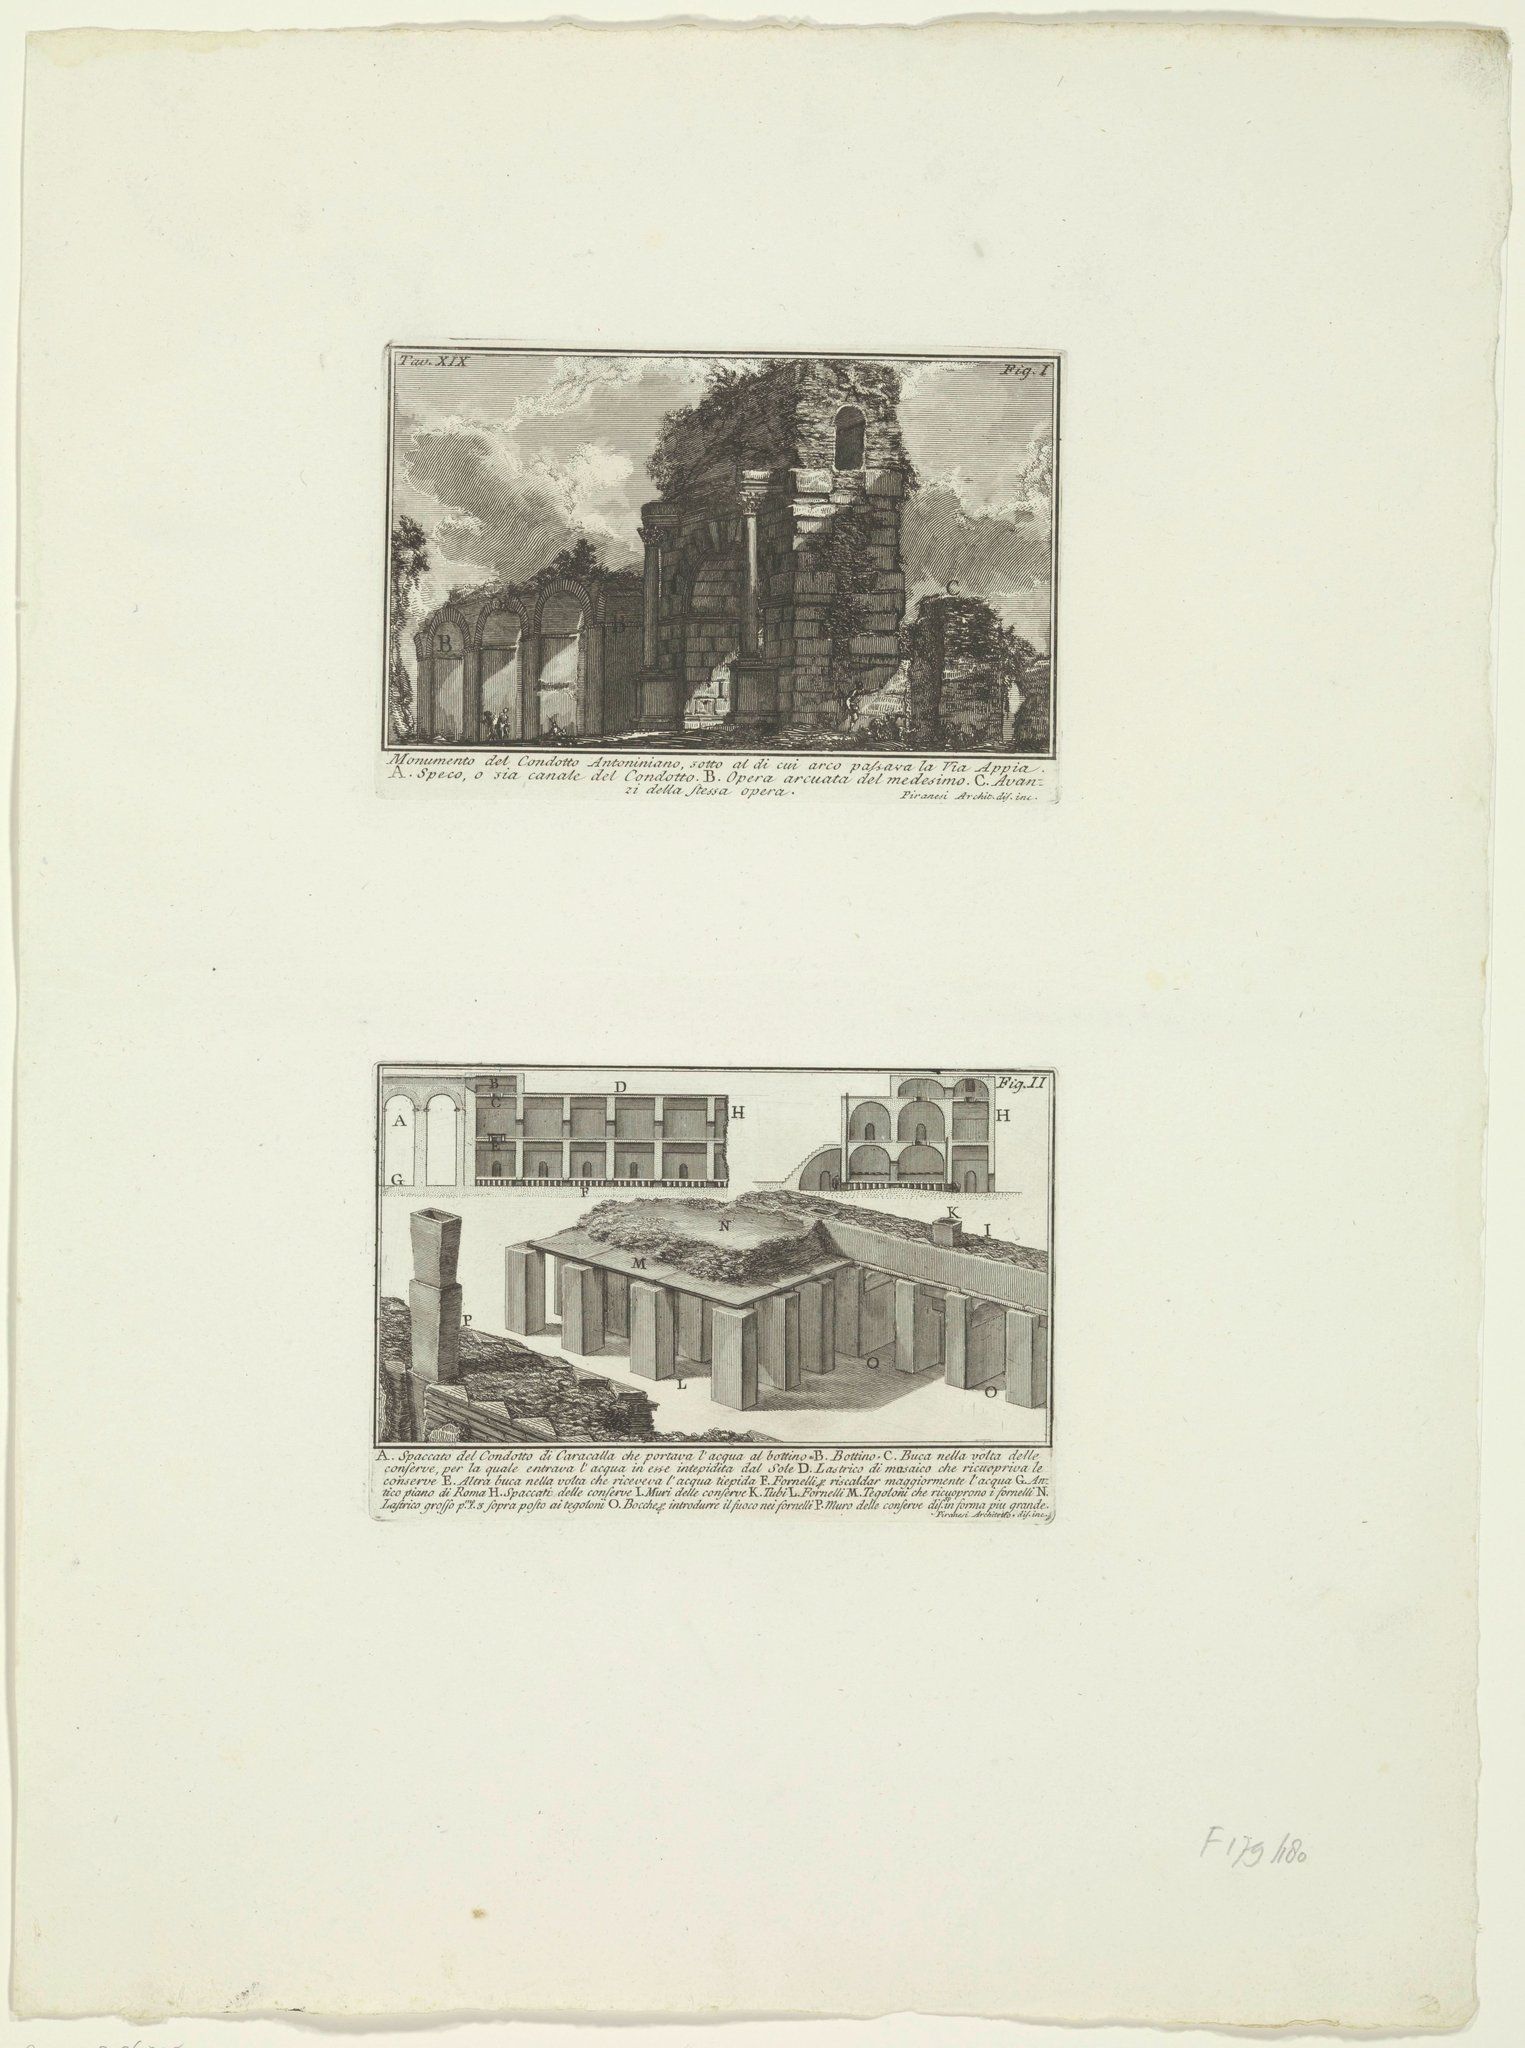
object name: print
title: Aqua Antoniniana en waterwegen van de Thermen van Caracalla te Rome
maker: giovanni battista piranesi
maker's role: designer, draughtsman, print maker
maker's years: 1720-1778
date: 1756-1757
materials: paper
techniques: etching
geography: rome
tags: ruin of a building ~ architecture, landscape with bridge, viaduct or aqueduct, public baths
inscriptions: collector's mark: Lugt 2228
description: Blad met twee voorstellingen van Romeinse bouwwerken. Boven: gezicht op een poort ingebouwd in het aquaduct Aqua Antoniniana. Enkele reizigers op de onder de poort doorlopende Via Appia Antica. Genummerd linksboven: Tav. XIX. Genummerd rechtsboven: Fig. I. Titel en verklarende lijst met letters in ondermarge. Onder: schematische weergave van de waterwegen van de Thermen van Caracalla te Rome. Genummerd rechtsboven: Fig. II. Verklarende lijst met letters in ondermarge.